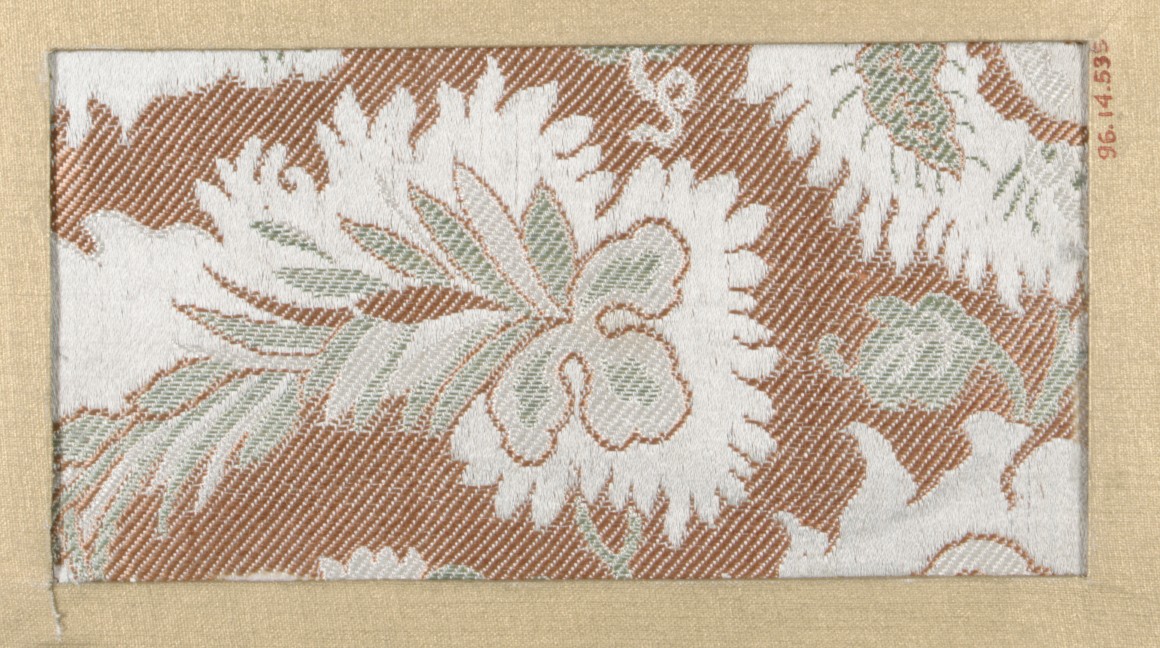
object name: piece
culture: japanese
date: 1701-1900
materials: silk